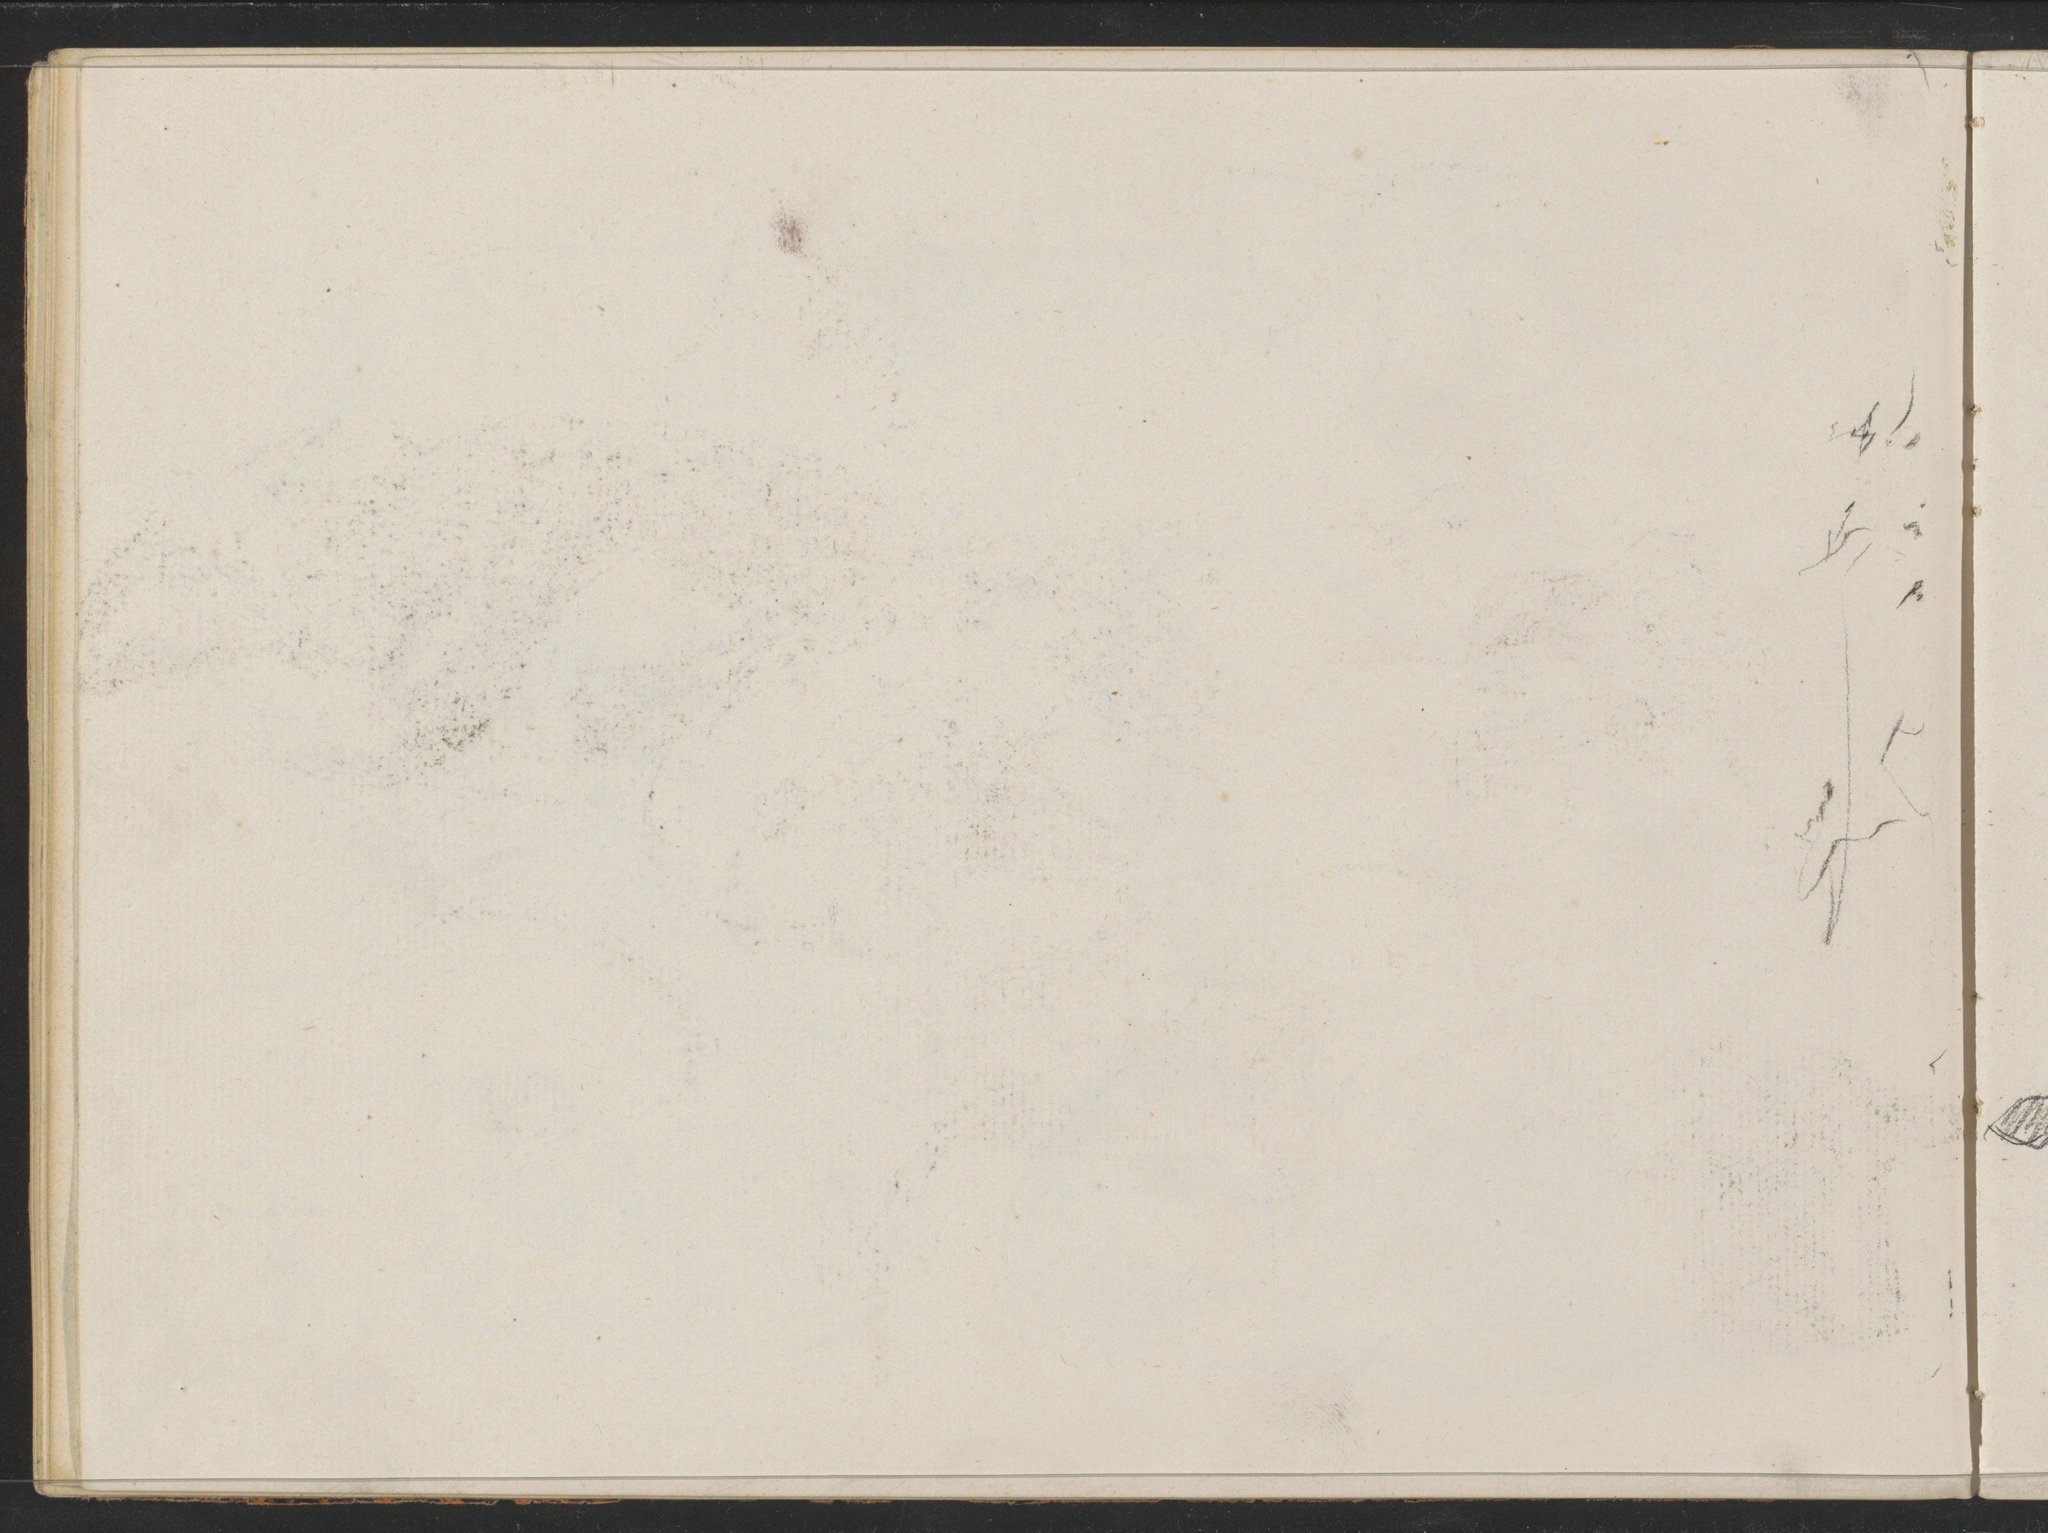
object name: sketchbook leaf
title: Studies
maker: ferdinand oldewelt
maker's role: draughtsman, print maker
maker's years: 1857-1935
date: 1904-1912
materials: chalk, paper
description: Blad 21 verso uit een schetsboek met 27 bladen.